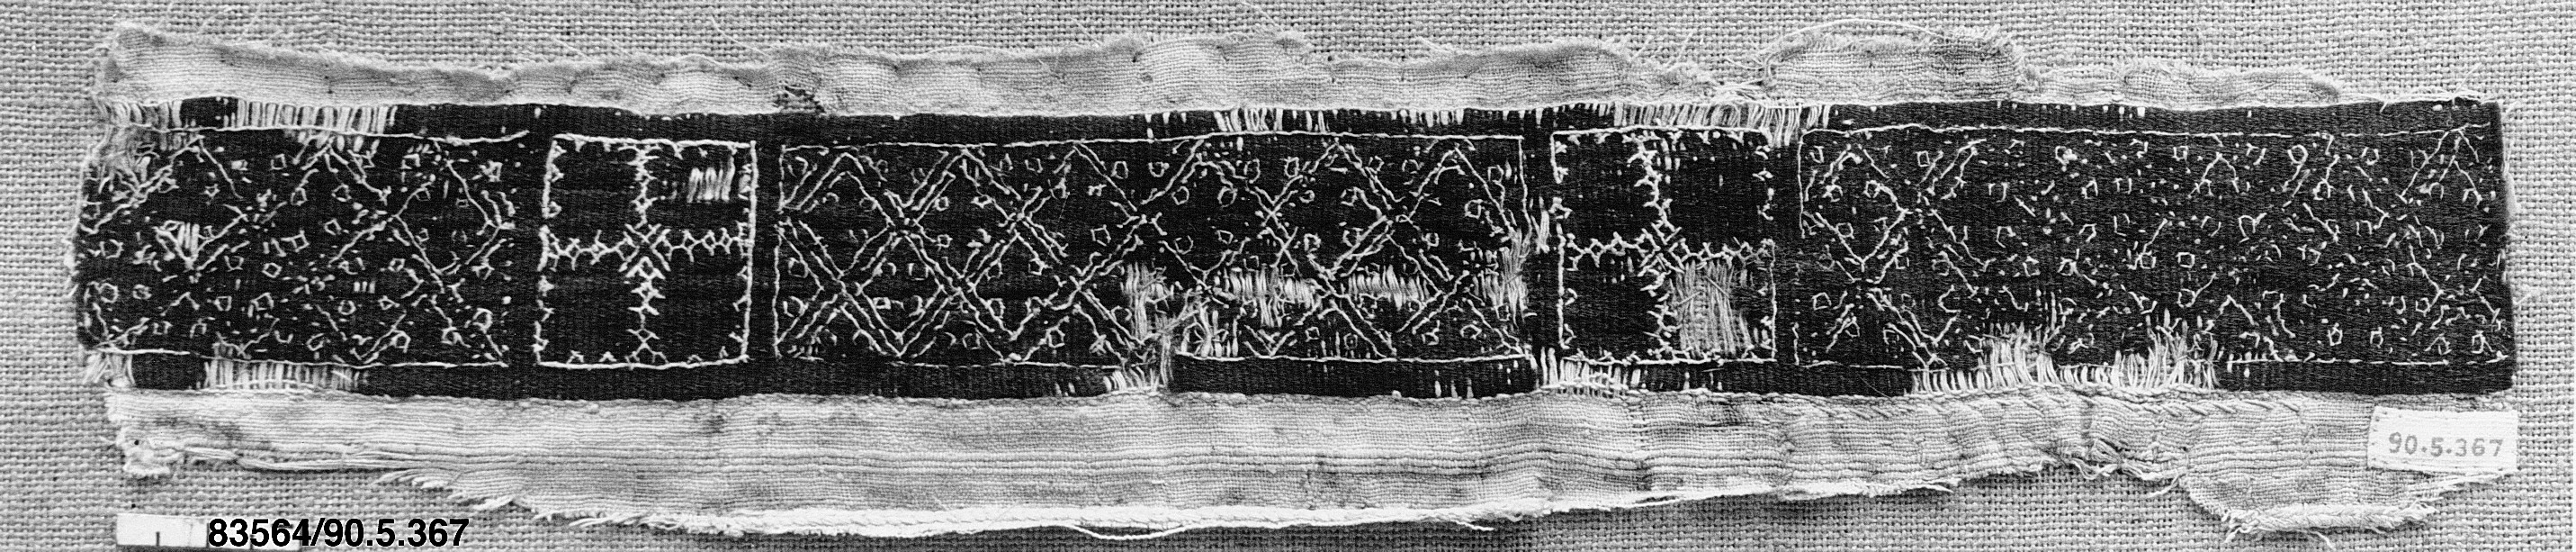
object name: textile fragment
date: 201-400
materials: linen, wool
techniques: weave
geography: egypt